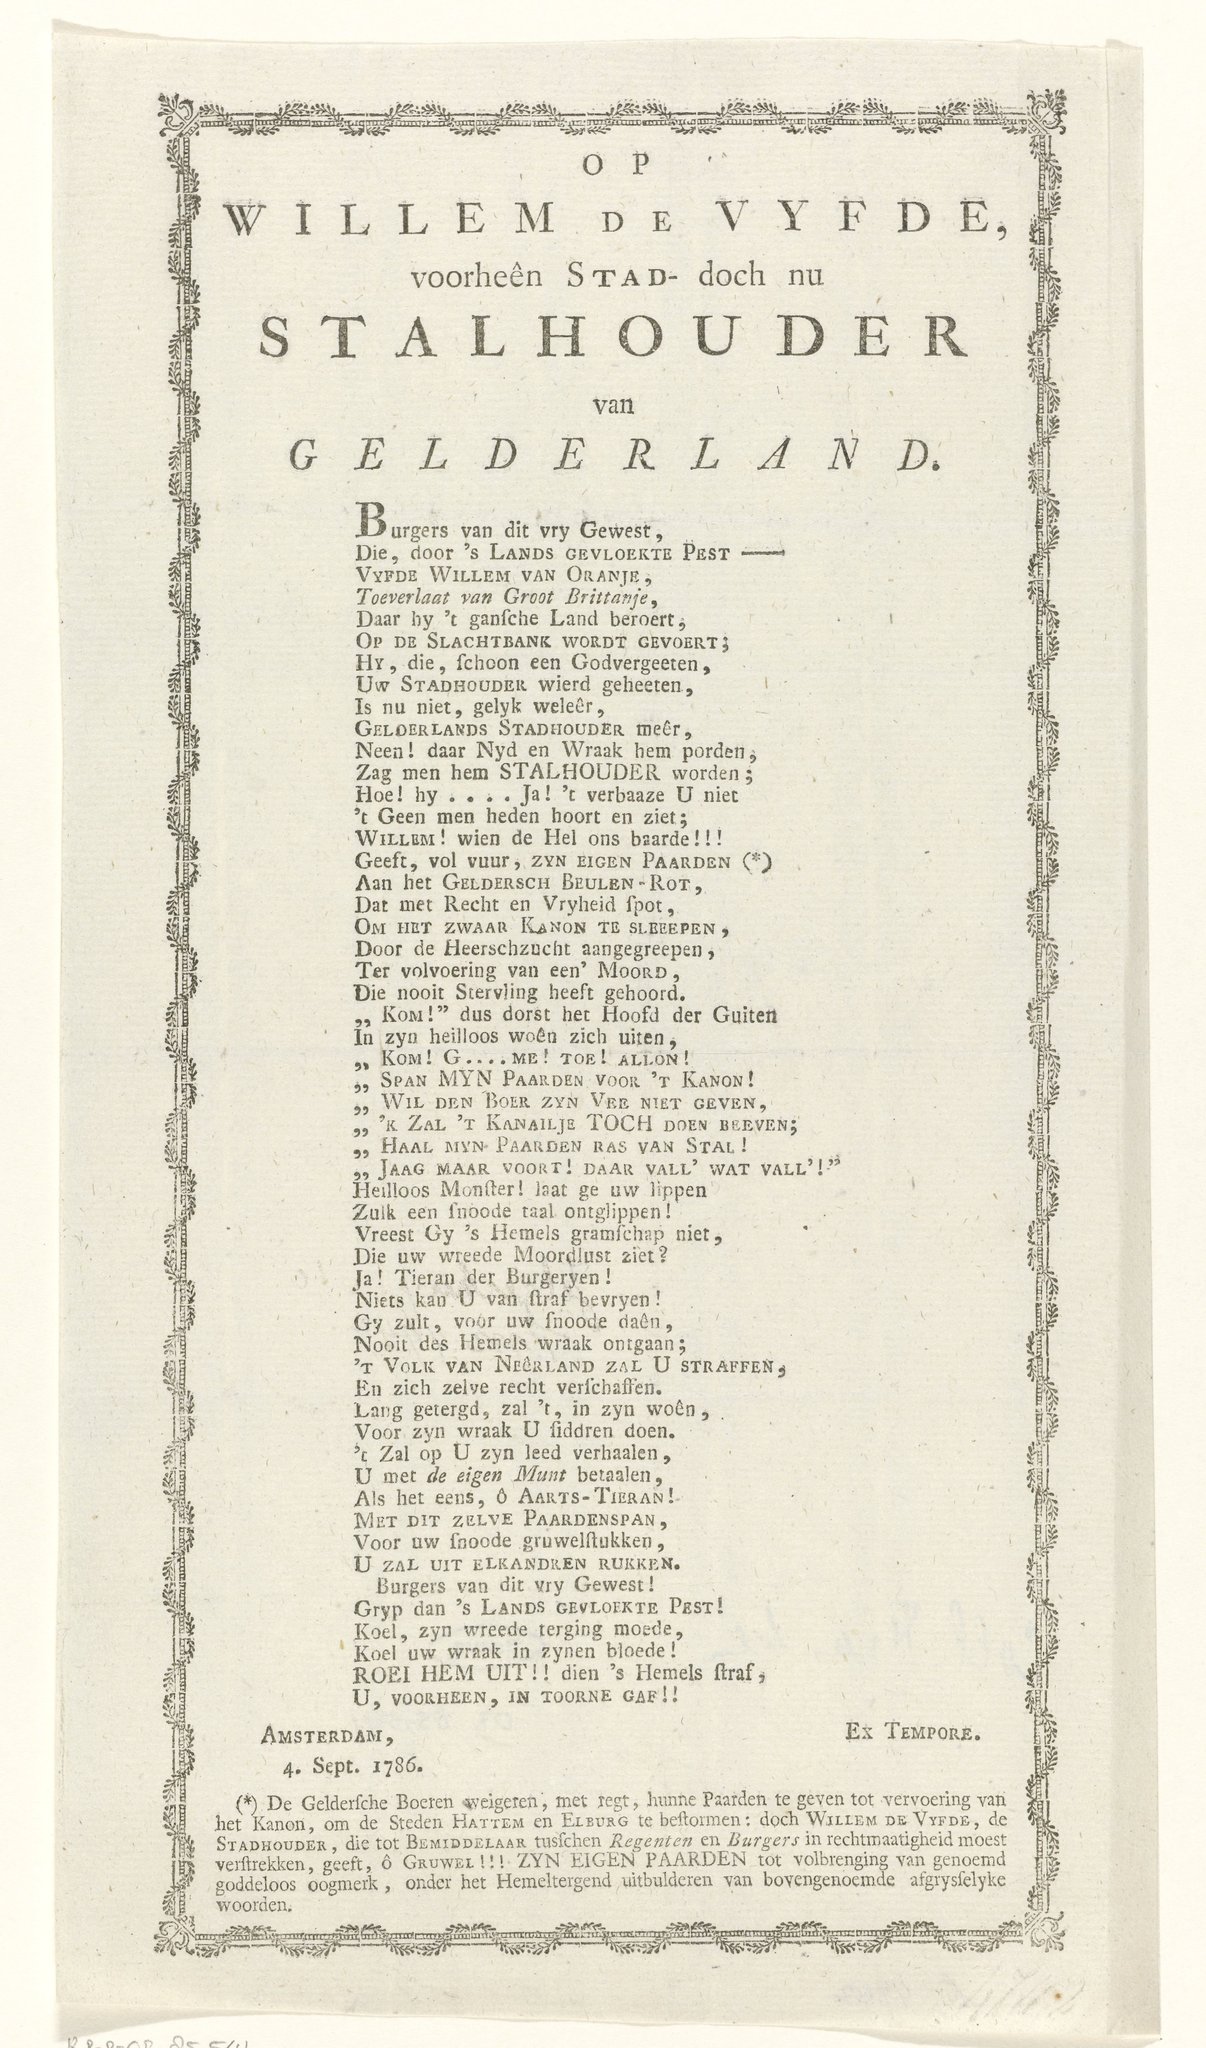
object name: text sheet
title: Spotdicht op Willem V, 1786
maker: Anonymous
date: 1786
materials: paper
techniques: letterpress printing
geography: amsterdam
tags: william v (prince of orange)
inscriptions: collector's mark: Lugt 2228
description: Spotdicht op Willem V naar aanleiding van het feit dat de stadhouder zijn eigen paarden gaf om de kanonnen naar Elburg en Hattem te vervoeren, begin september 1786. Vers van 54 regels binnen kader van fileten.